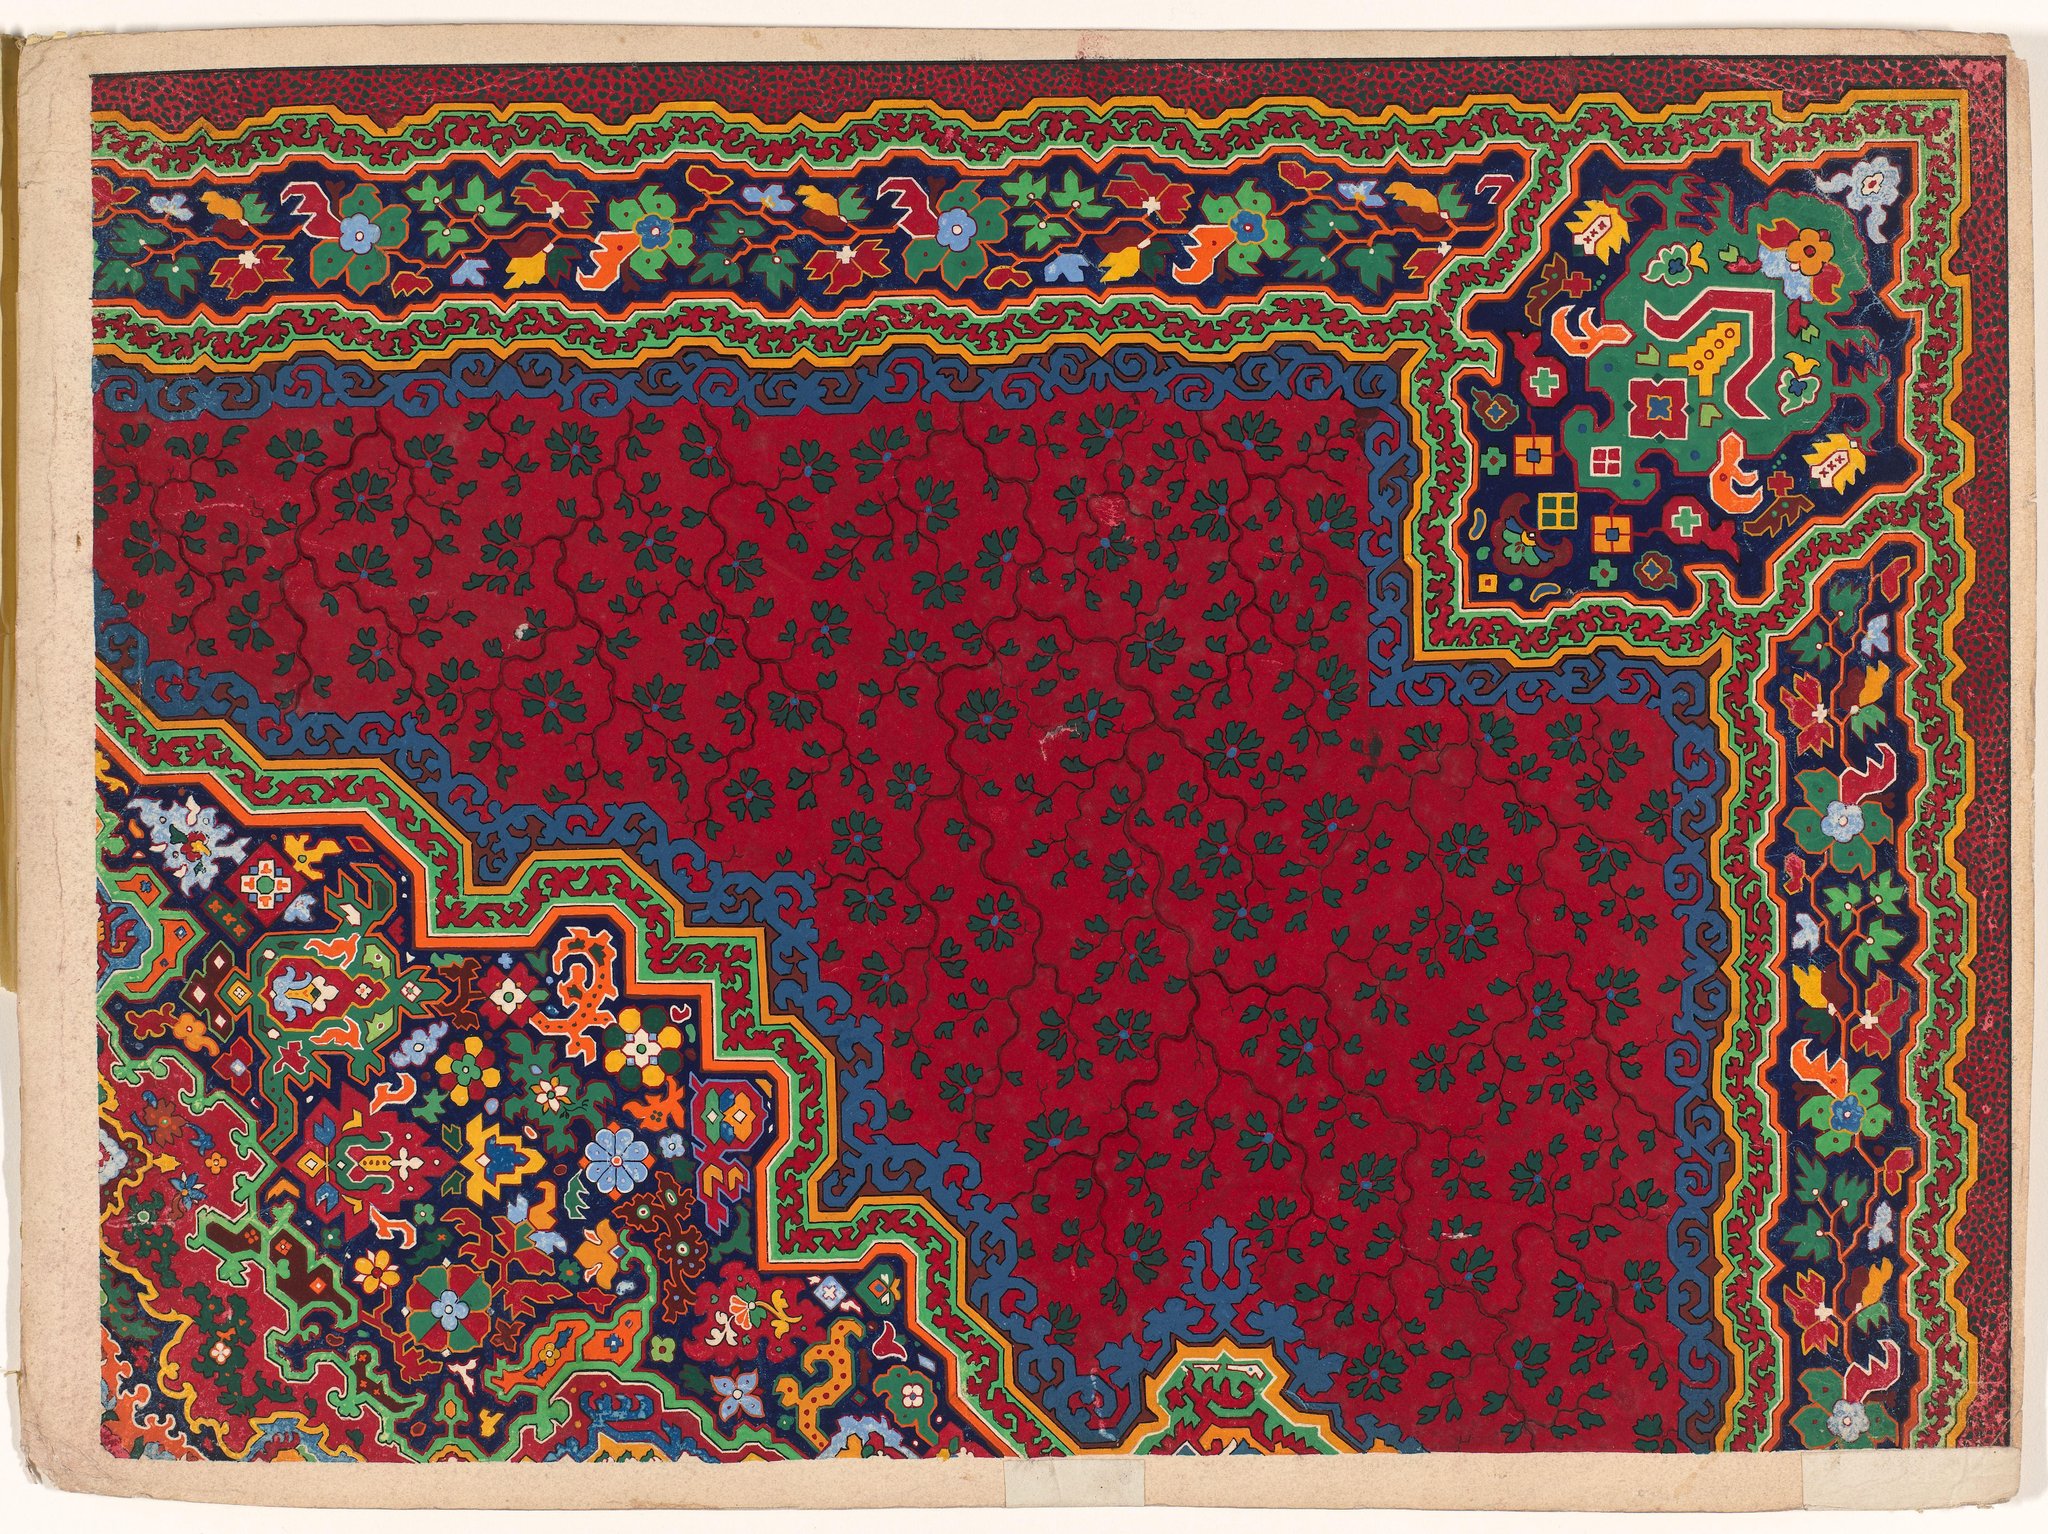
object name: design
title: Ontwerp voor een tapijt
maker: Anonymous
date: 1854-1864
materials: gouache, paper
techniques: brush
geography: amsterdam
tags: ornaments ~ art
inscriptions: number: ‘No 46 A.’, retailer's mark: ‘JHS.’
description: De presentatietekeningen BK-1971-77-1 t/m 86 zijn kopieën van de originele ontwerptekeningen. Ze werden gemaakt voor vertegenwoordigers van bijvoorbeeld magazijnen, die ze aan hun klanten konden tonen. De meeste tekeningen tonen een kwart van het dessin inclusief rand, middenpartij (de zogenaamde grond of fond) en centraal medaillon. Door het gebruik van spiegels kan de illusie van het gehele tapijt worden opgeroepen. Een deel van de tekeningen heeft een alfabetische opeenvolgende letter als kenmerk, de andere groep een cijfer.Waarschijnlijk is de reeks dessins met een letter eerder samengesteld dan de genummerde tekeningen.